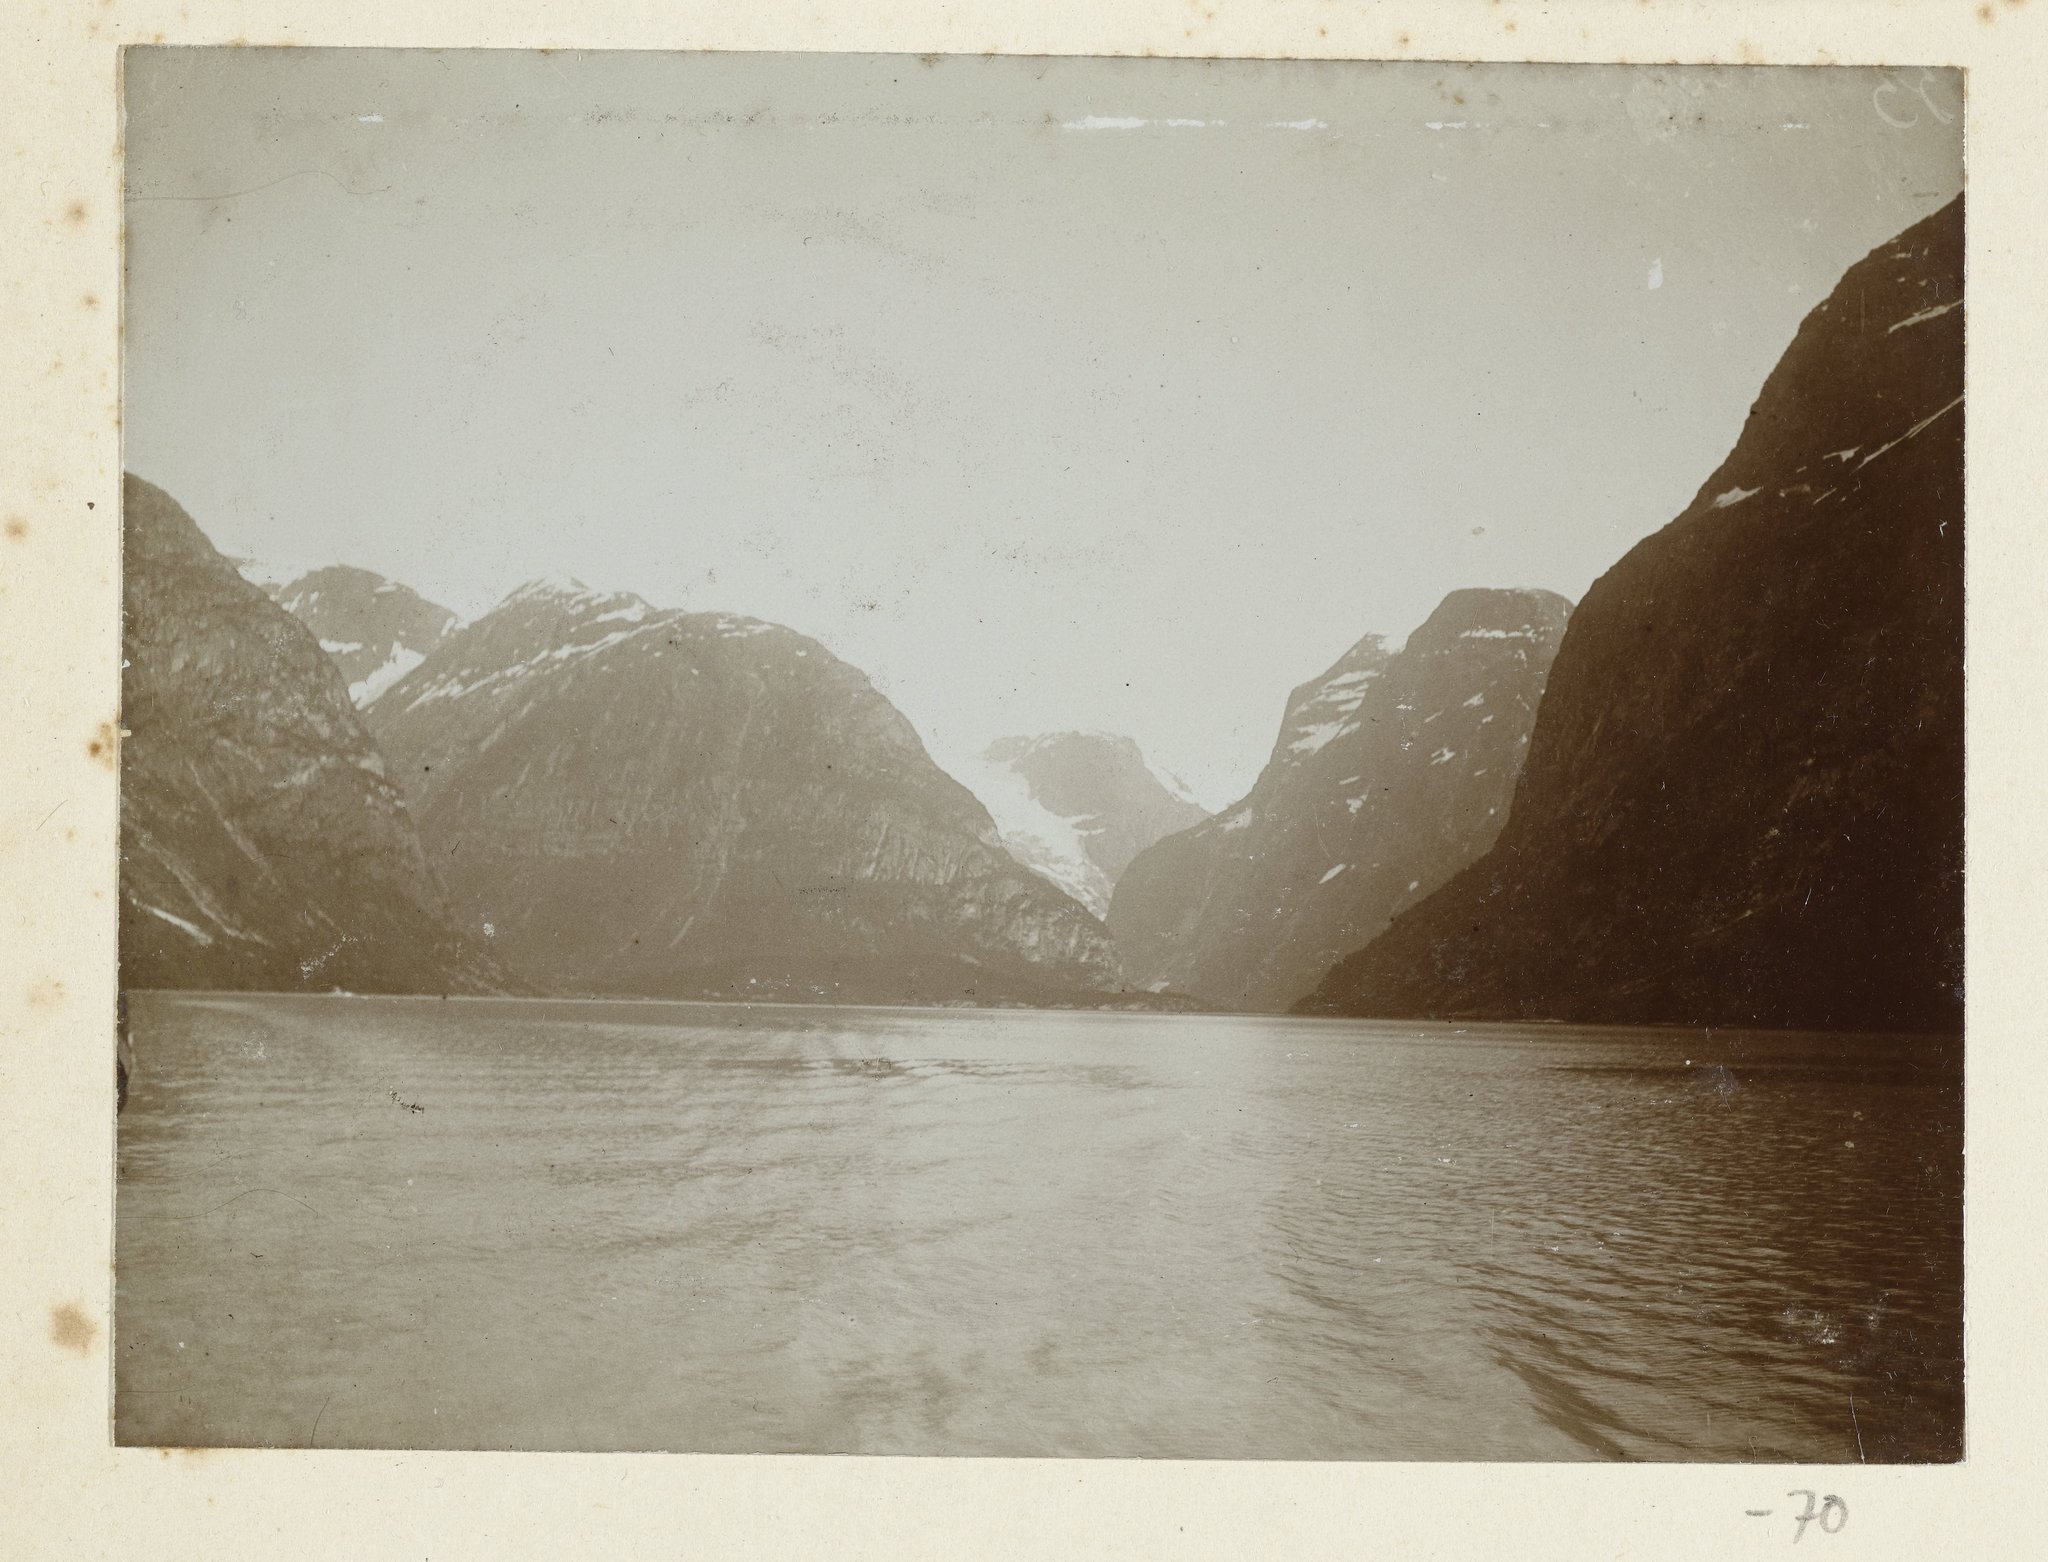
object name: photograph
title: Gezicht op een bergmeer in de Harz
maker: geldolph adriaan kessler (dolph)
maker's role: fotograaf, industrieel, voetballer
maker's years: 1884-1945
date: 1903-1908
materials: cardboard, photographic support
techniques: gelatin silver print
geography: harz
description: Gezicht op een bergmeer in vermoedelijk de Harz. Onderdeel van het fotoalbum van Dolph Kessler met opnamen die hij maakte tijdens zijn verblijf in Engeland en op een wereldreis die hij als secretaris van Henri Deterding (directeur Koninklijke Olie) ondernam naar Nederlands-Indië, Japan, China en de Verenigde Staten, tussen 1906 en 1908.